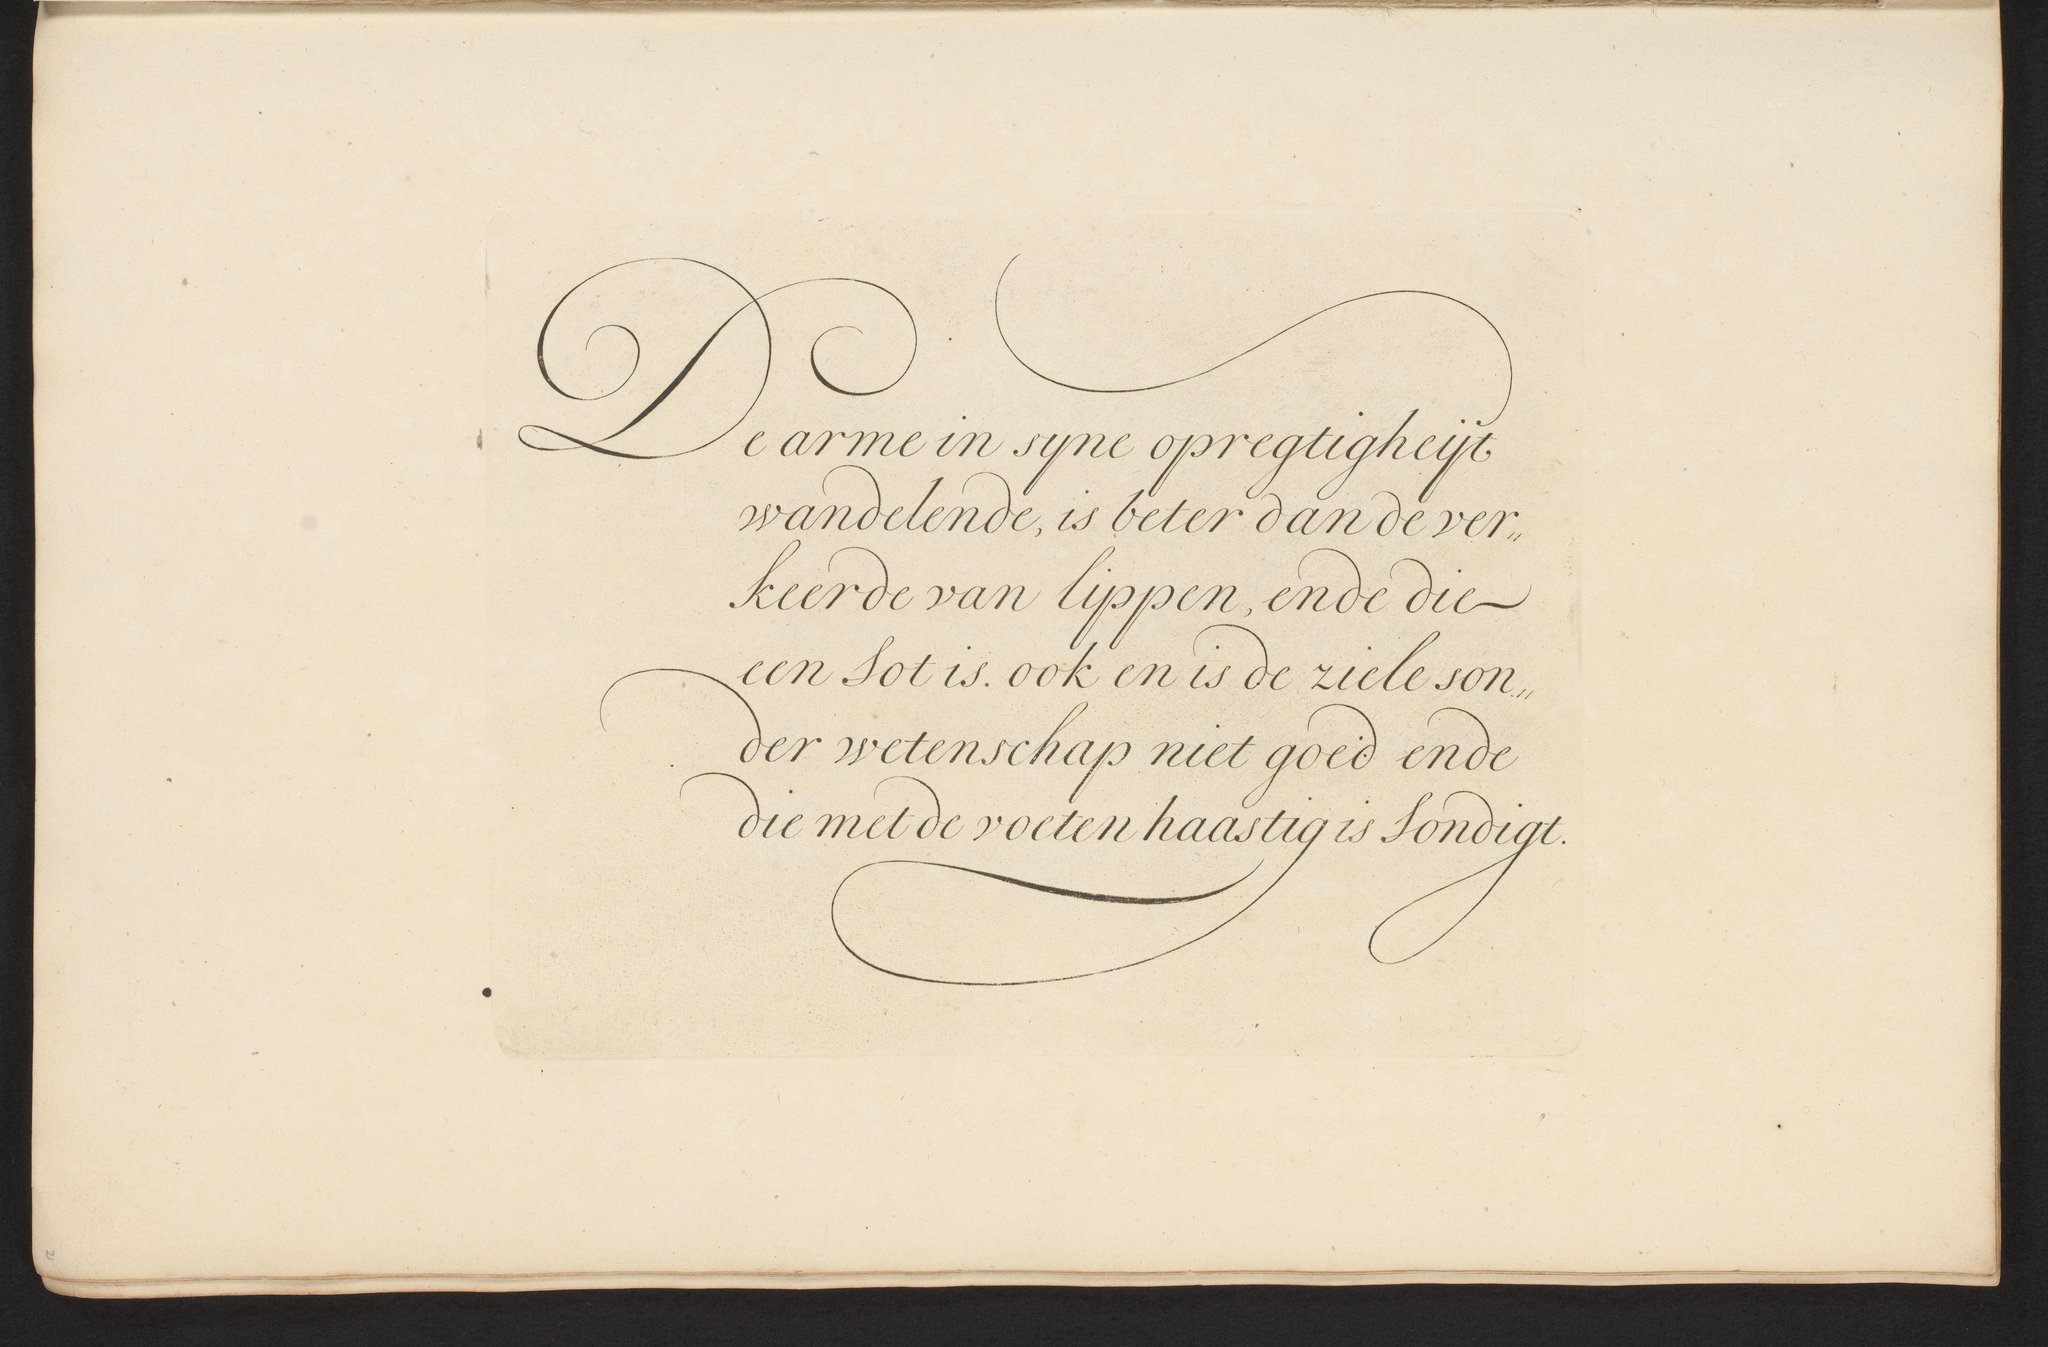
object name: print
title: Schrijfvoorbeeld: De arme in syne opregtigheijt (...)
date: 1660-1751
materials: paper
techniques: engraving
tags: calligraphy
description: Schrijfvoorbeeld met zes regels tekst in het Nederlands: De arme in syne opregtigheijt ... De prent maakt deel uit van een album